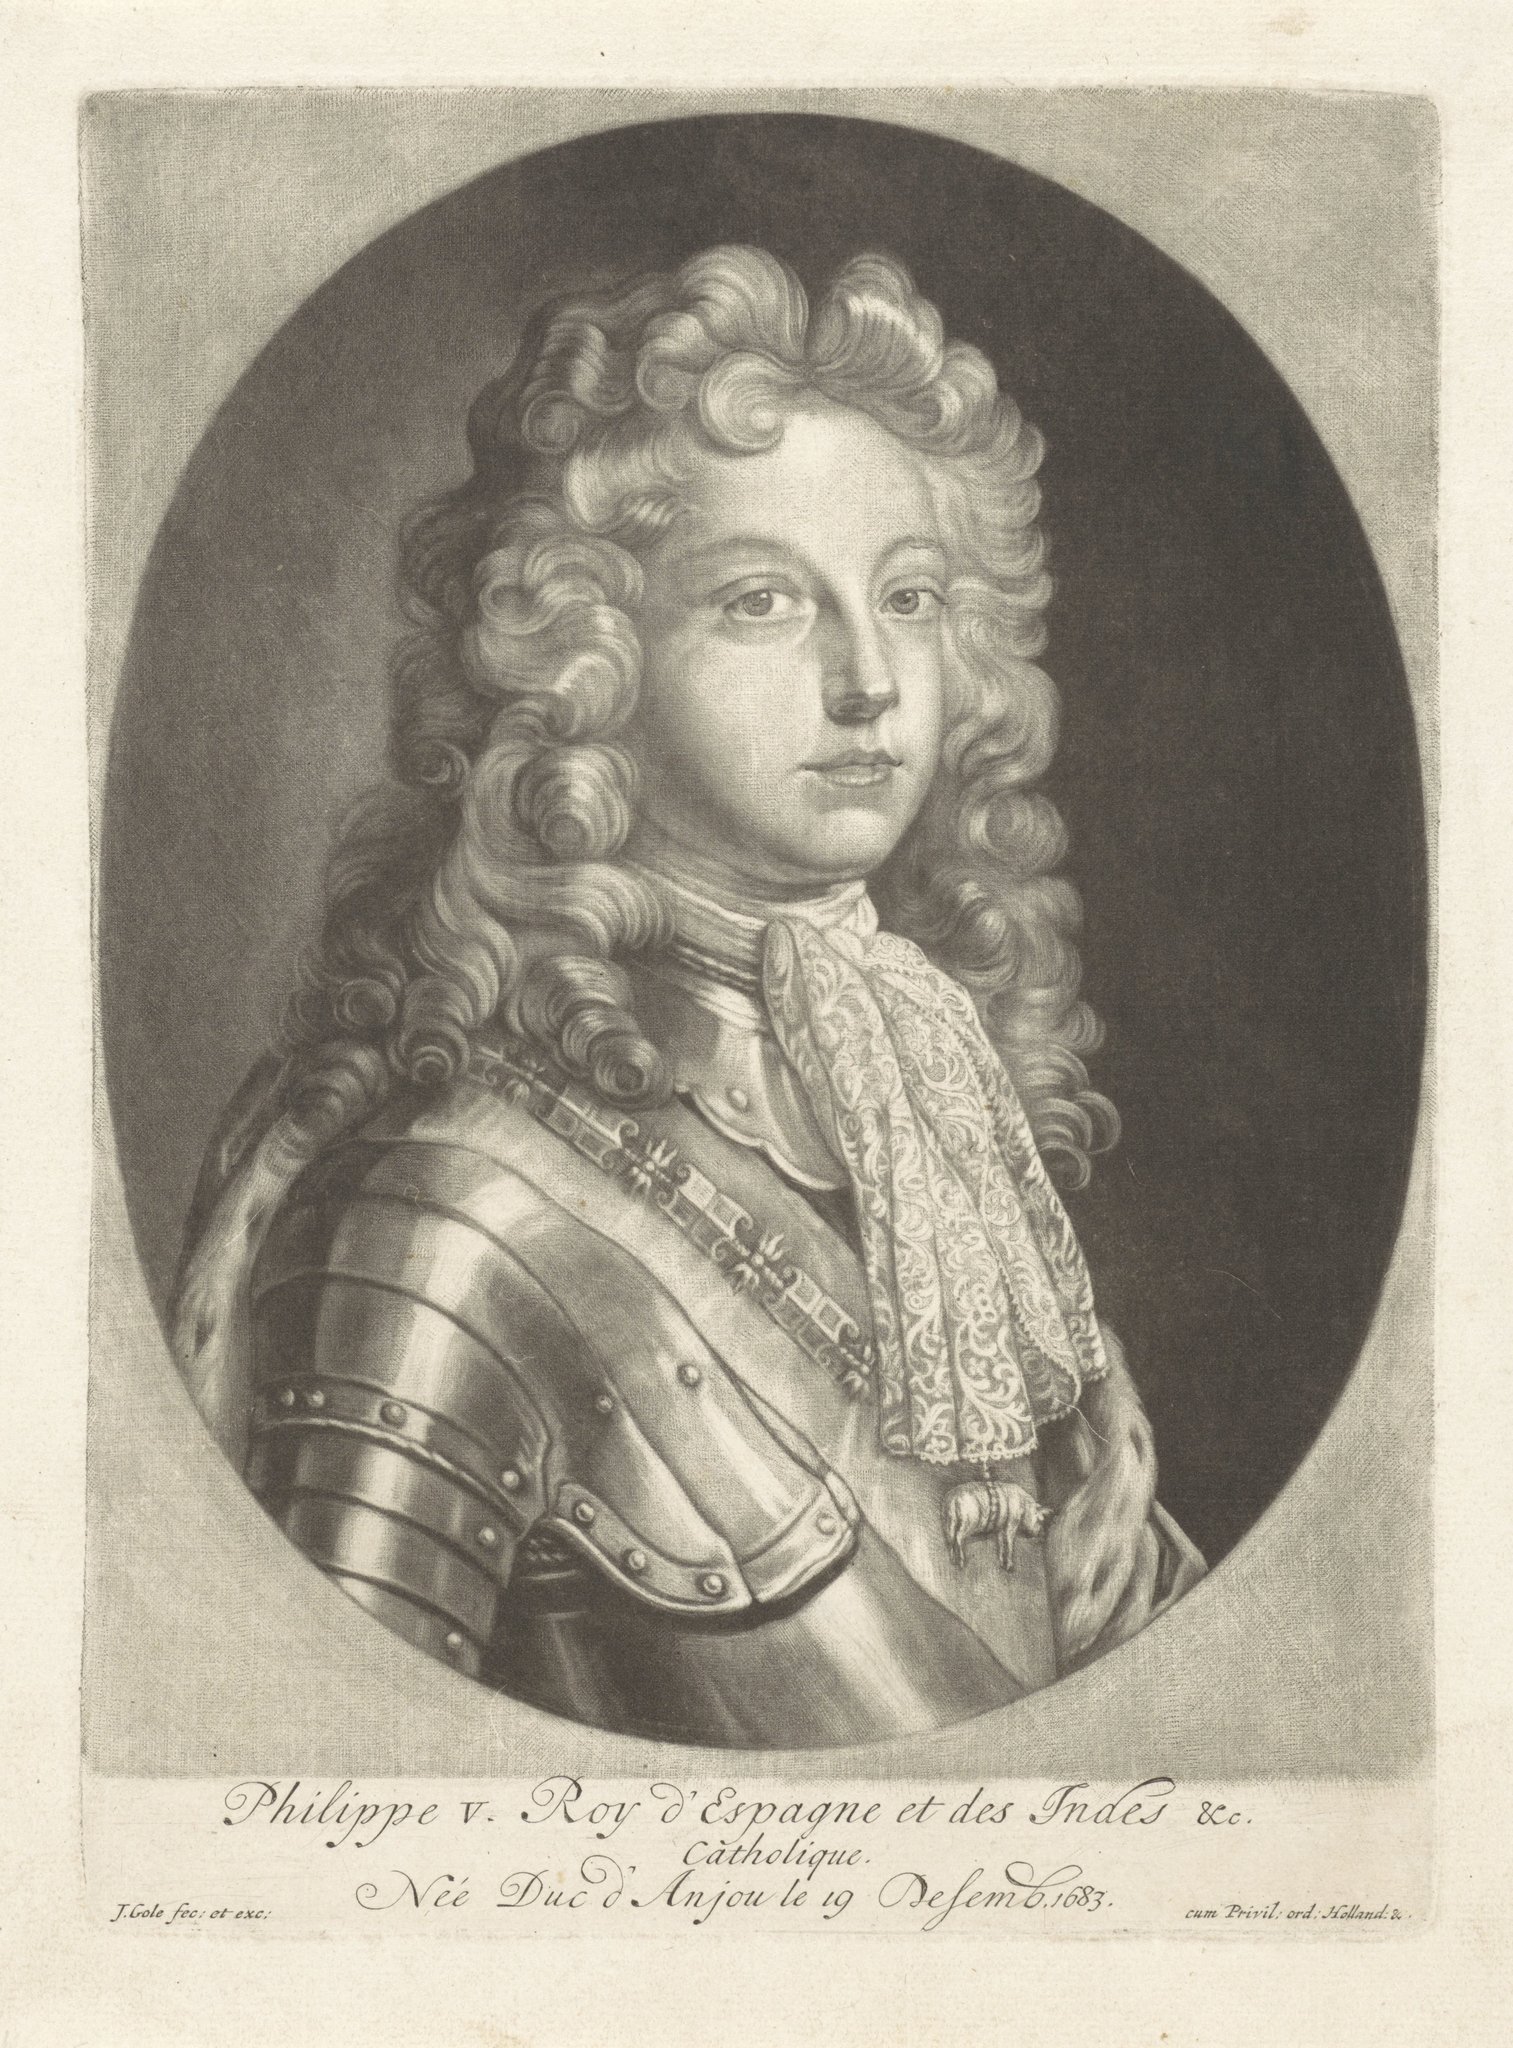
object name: print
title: Portret van Filips V, koning van Spanje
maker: jacob gole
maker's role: print maker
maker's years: 1660-1724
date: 1700-1724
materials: paper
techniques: engraving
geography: amsterdam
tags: filips v (koning van spanje), knighthood order of the golden fleece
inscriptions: collector's mark: Lugt 2228, collector's mark: Lugt 2028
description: De jonge hertog Filips van Anjou, vanaf 1700 koning Filips V van Spanje. Hij draagt een harnas en een keten met het ordeteken van de Orde van het Gulden Vlies.